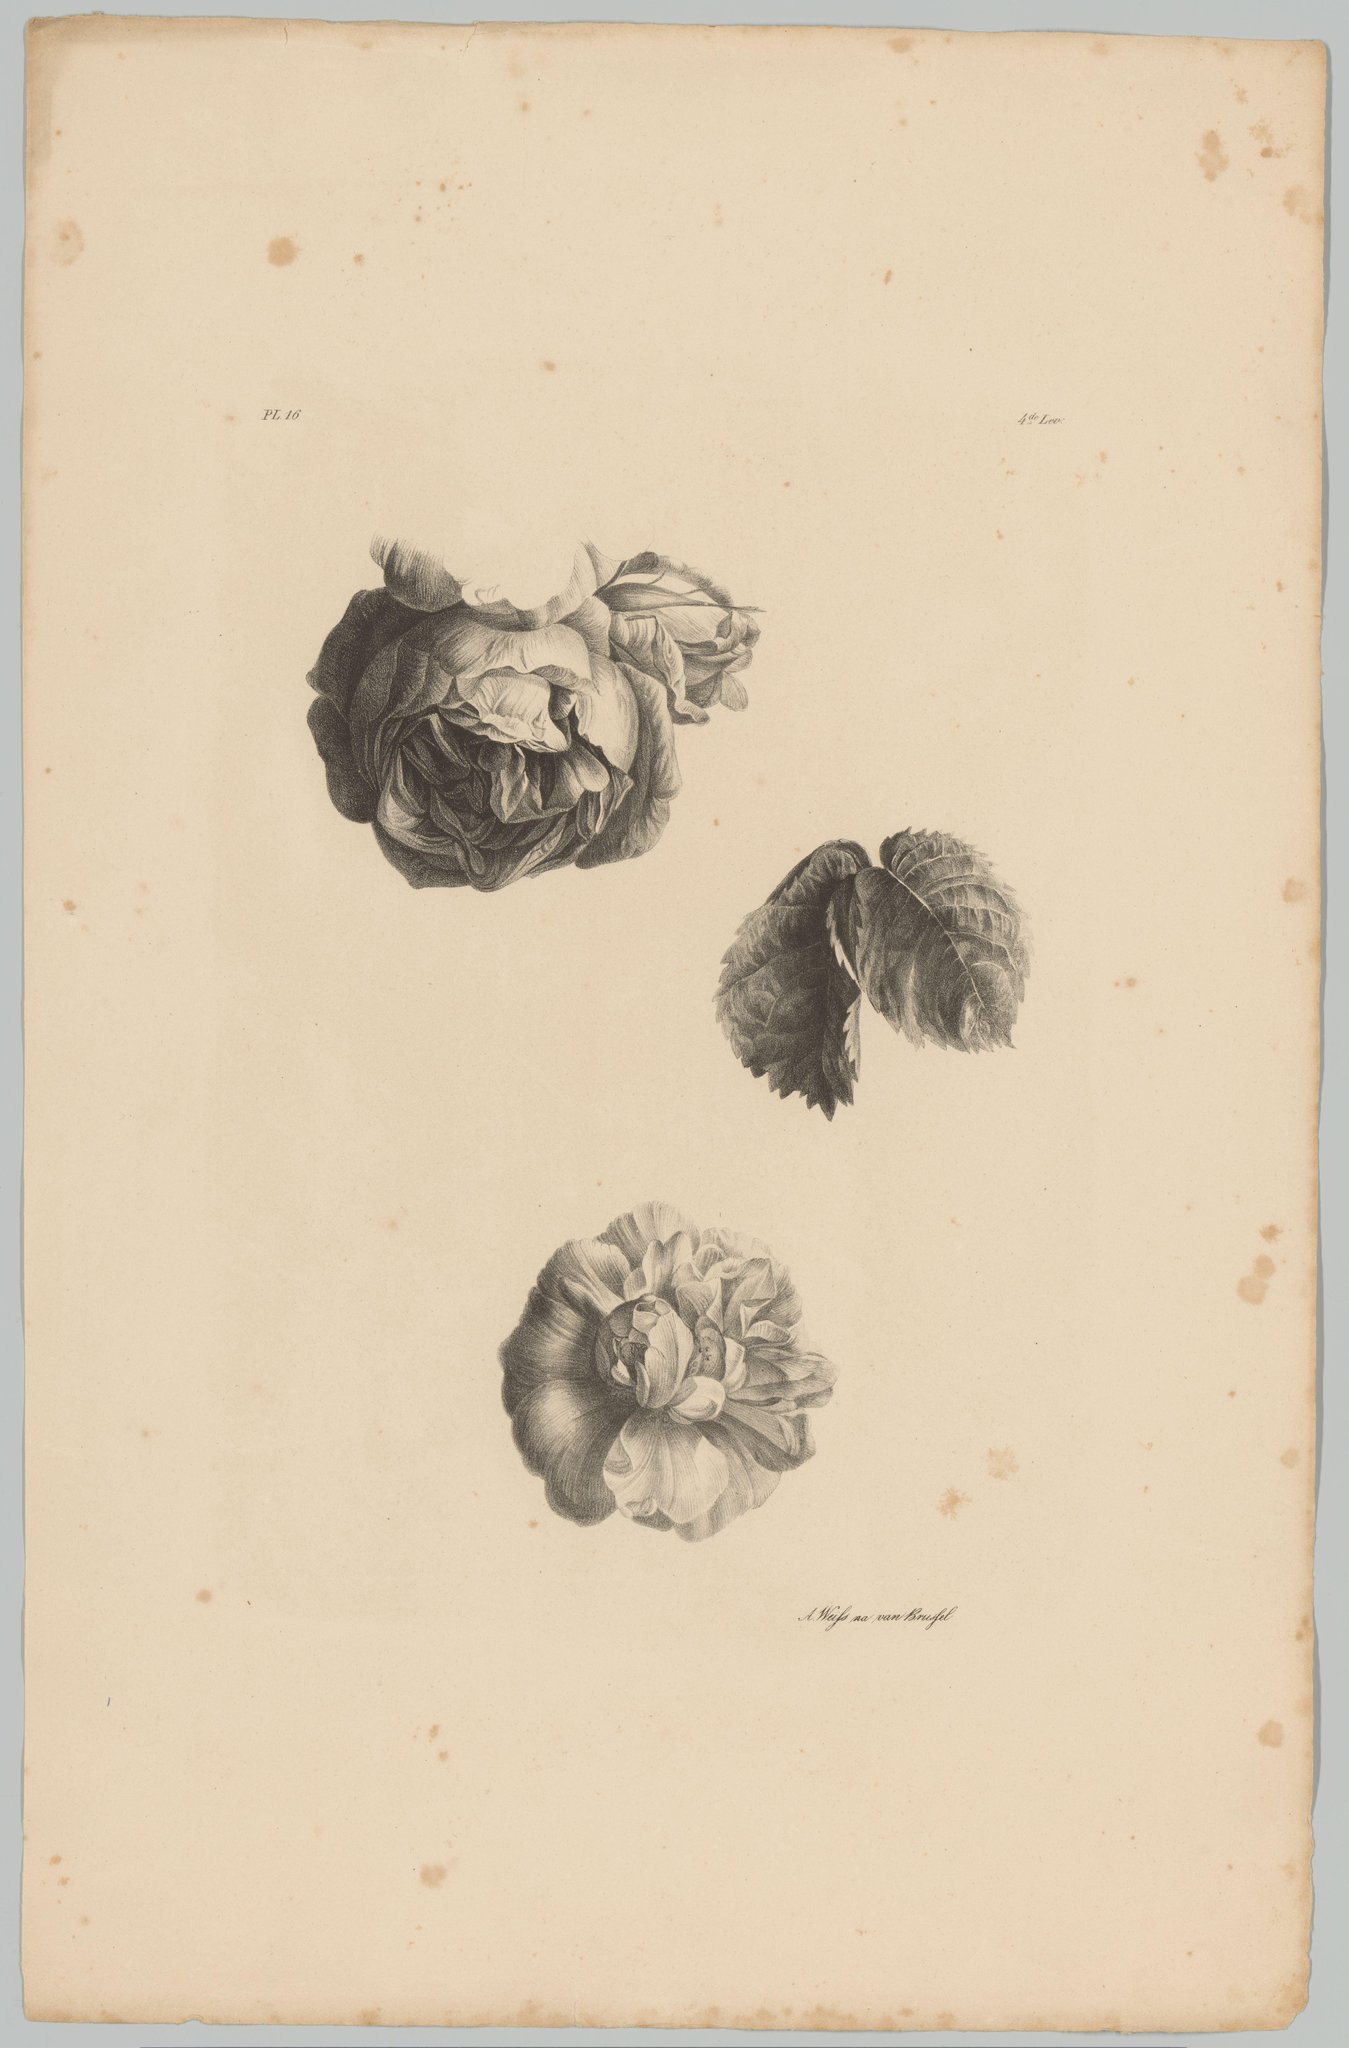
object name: print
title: Bloem en Fruit Studien (...) 3de aflevering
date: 1820-1833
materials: paper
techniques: lithograph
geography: amsterdam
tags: flowers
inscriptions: collector's mark: Lugt 2228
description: Rechts boven genummerd 4de Lev. Onderdeel van een omslag met in totaal zevenenzeventig lithografieën van bloemen en fruit.